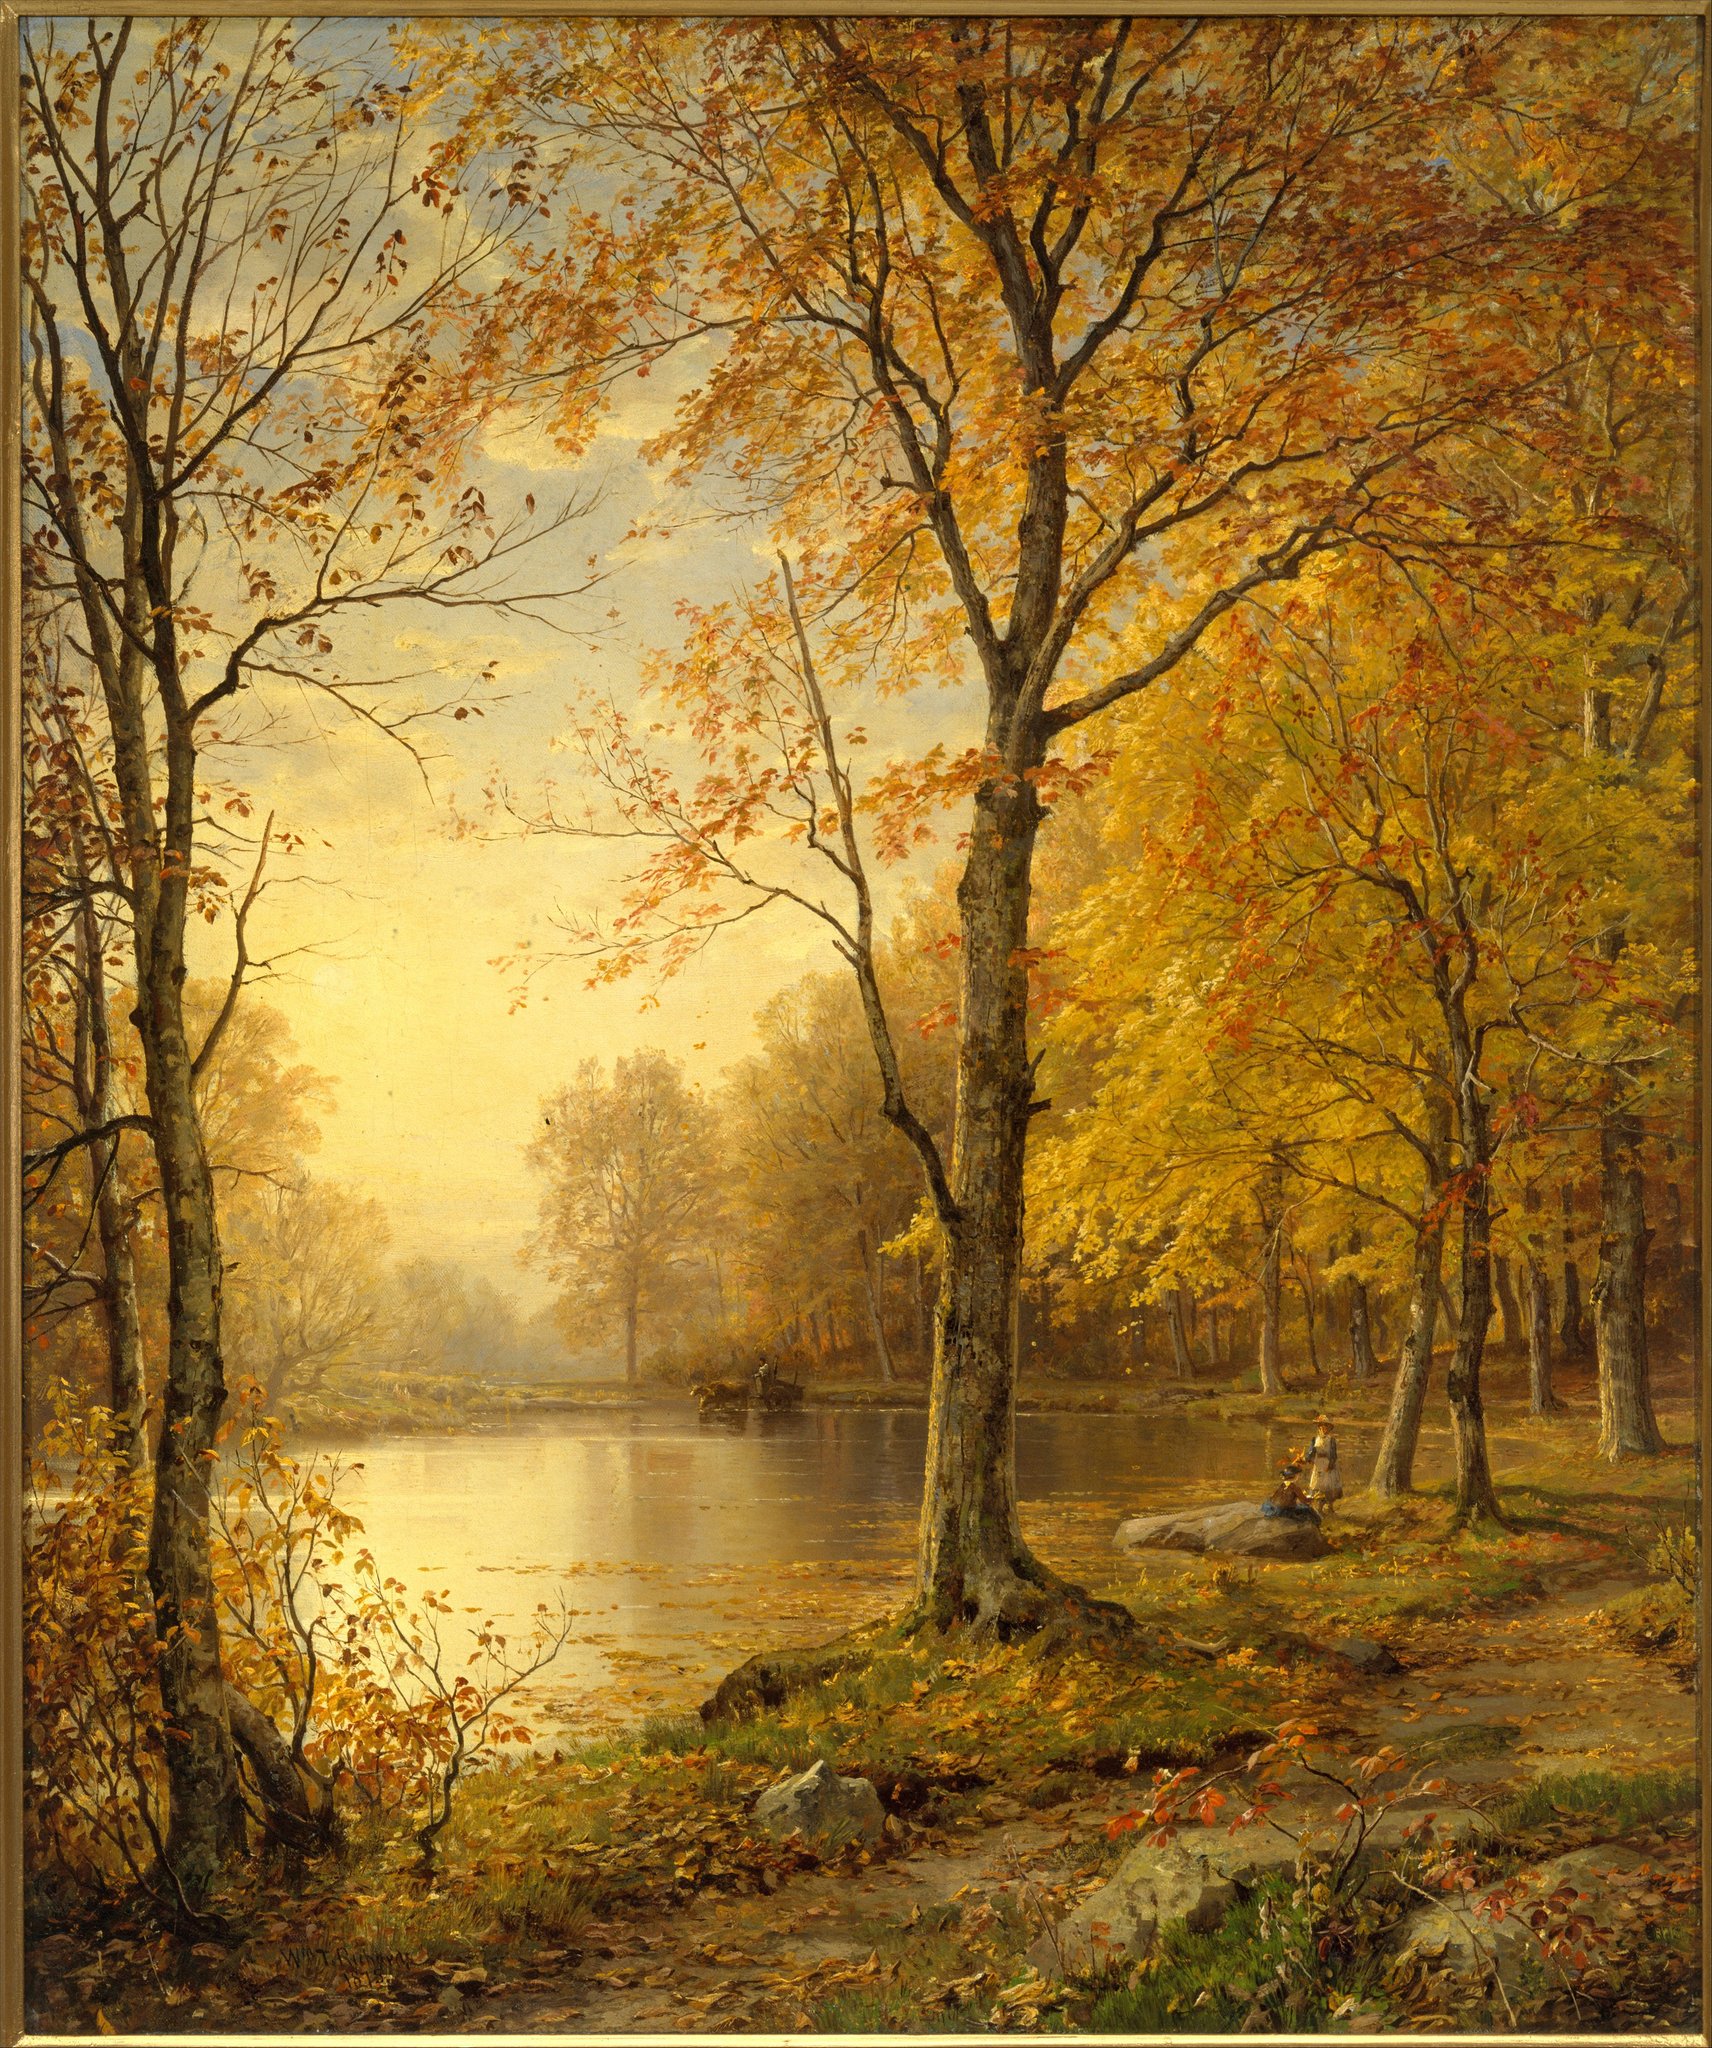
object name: painting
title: Indian Summer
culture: american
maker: william trost richards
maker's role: artist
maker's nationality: american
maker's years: 1833-1905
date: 1875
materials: canvas, oil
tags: landscapes,trees,summer